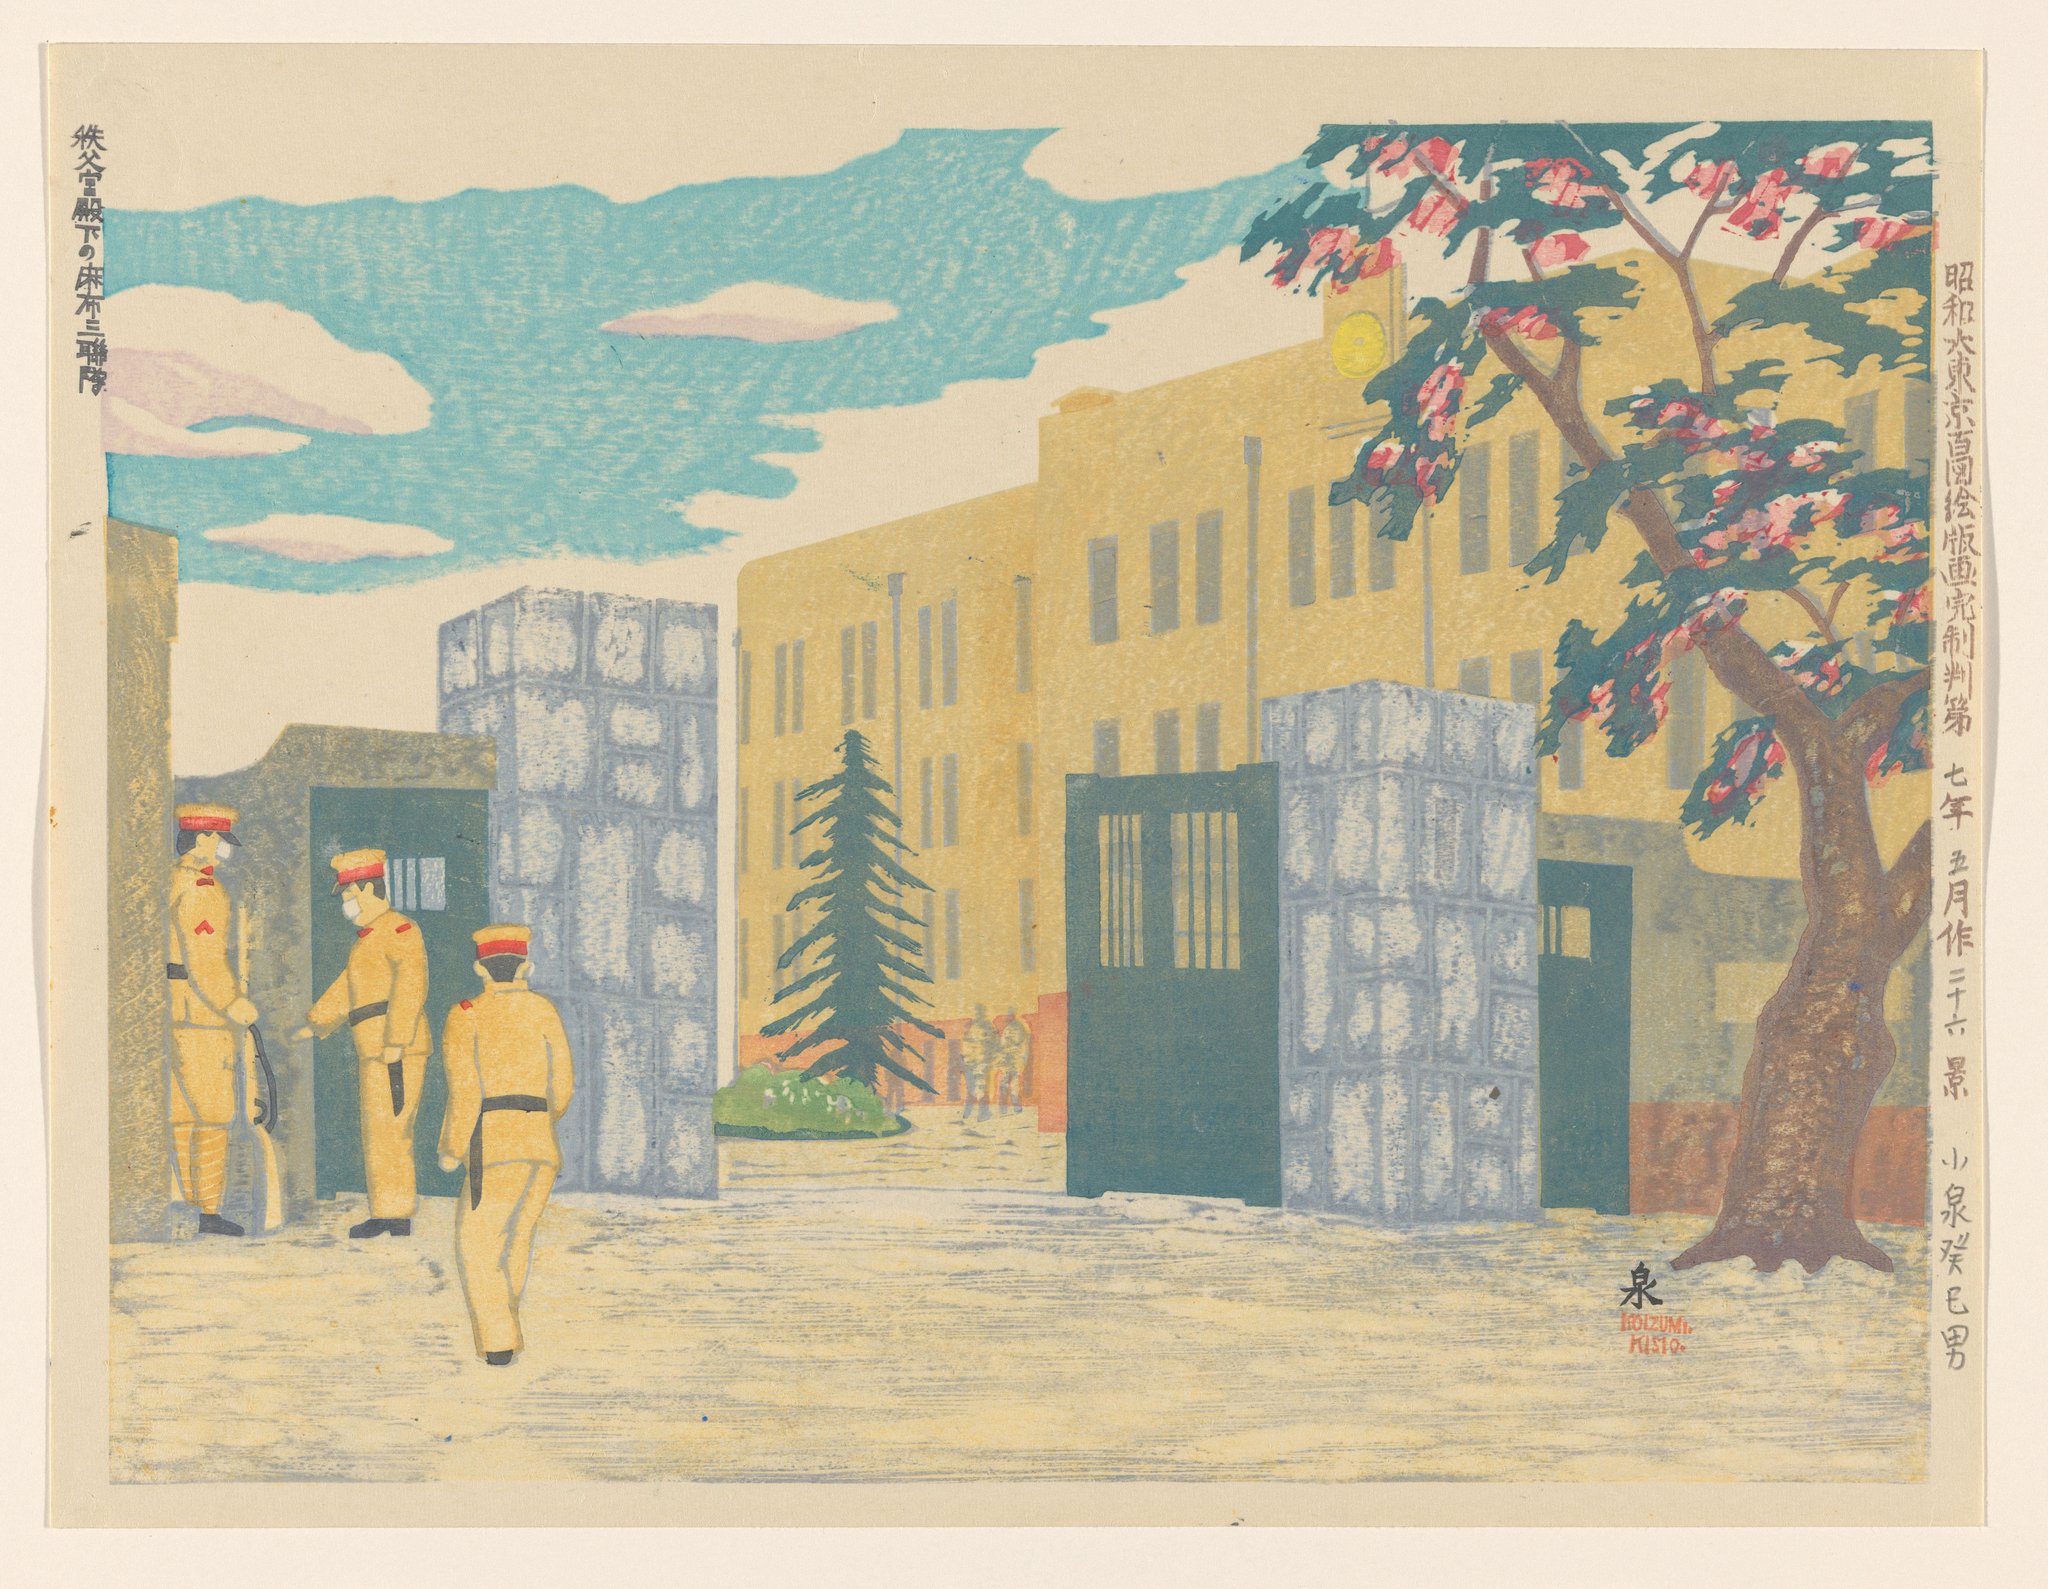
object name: print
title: Shōwa dai Tōkyō hyakuzue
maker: koizumi kishio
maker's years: 1893-1945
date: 1905-1932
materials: paper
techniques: woodcut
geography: japan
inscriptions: signature: ‘小泉癸巳男’, signature: ‘泉’, seal: ‘Koizumi Kishio.’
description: Drie militairen staan bij de poort van het hoofdkwartier van het derde regiment in Azabu, Tokyo. In september 1928 begon Koizumi Kishio aan zijn ambitieuze plan om honderd landschapsprenten met scènes in Tokyo volledig zelf te ontwerpen, hiervan zelf de drukblokken te snijden en zelf de prenten te drukken. De aanleiding voor het project was grote verandering die Tokyo onderging door de verwoestende Grote Kantō-aardbeving van 1923 en de wederopbouw die daarop volgde. Kishio maakt een bewuste verwijzing naar de bekende serie ‘Honderd beroemde gezichten op Edo’ door Utagawa Hiroshige (1797–1858), met prenten van locaties in Edo—de oude benaming voor Tokyo. Kishio toont overwegend moderne gebouwen, instituten en mensen die de tijdsgeest van de jaren 1920 en 1930 weerspiegelen. Sommige prenten onthullen daarentegen een nostalgische blik op overblijfselen uit het oude Edo. Kishio verkocht de prenten aan de hand van een abonnement met een limiet van vijftig leden, die elke maand een of twee prenten zouden ontvangen. Het project begon met negen abonnementen, maar al na de tweede maand werden meerdere daarvan opgezegd en slechts vier mecenassen bleven lid tot en met de voltooiing van de serie. Hij bracht het honderdste ontwerp uit in 1937. Zijn leermeester Ishii Hakutei schreef een inleiding in 1938 die Kishio verwerkte tot een prent en toevoegde aan de set. Tussen 1939 en 1940 maakte hij nog eens negen extra ontwerpen. Met acht van deze ontwerpen verving hij oudere nummers uit de serie, mogelijk omdat hij niet tevreden was met de composities. Uiteindelijk lukte het Kishio om tien complete sets te verkopen aan de shin hanga-uitgever Watanabe Shōzaburō en liet hiervoor speciale houten dozen maken. Deze prent behoort tot een van die tien sets.